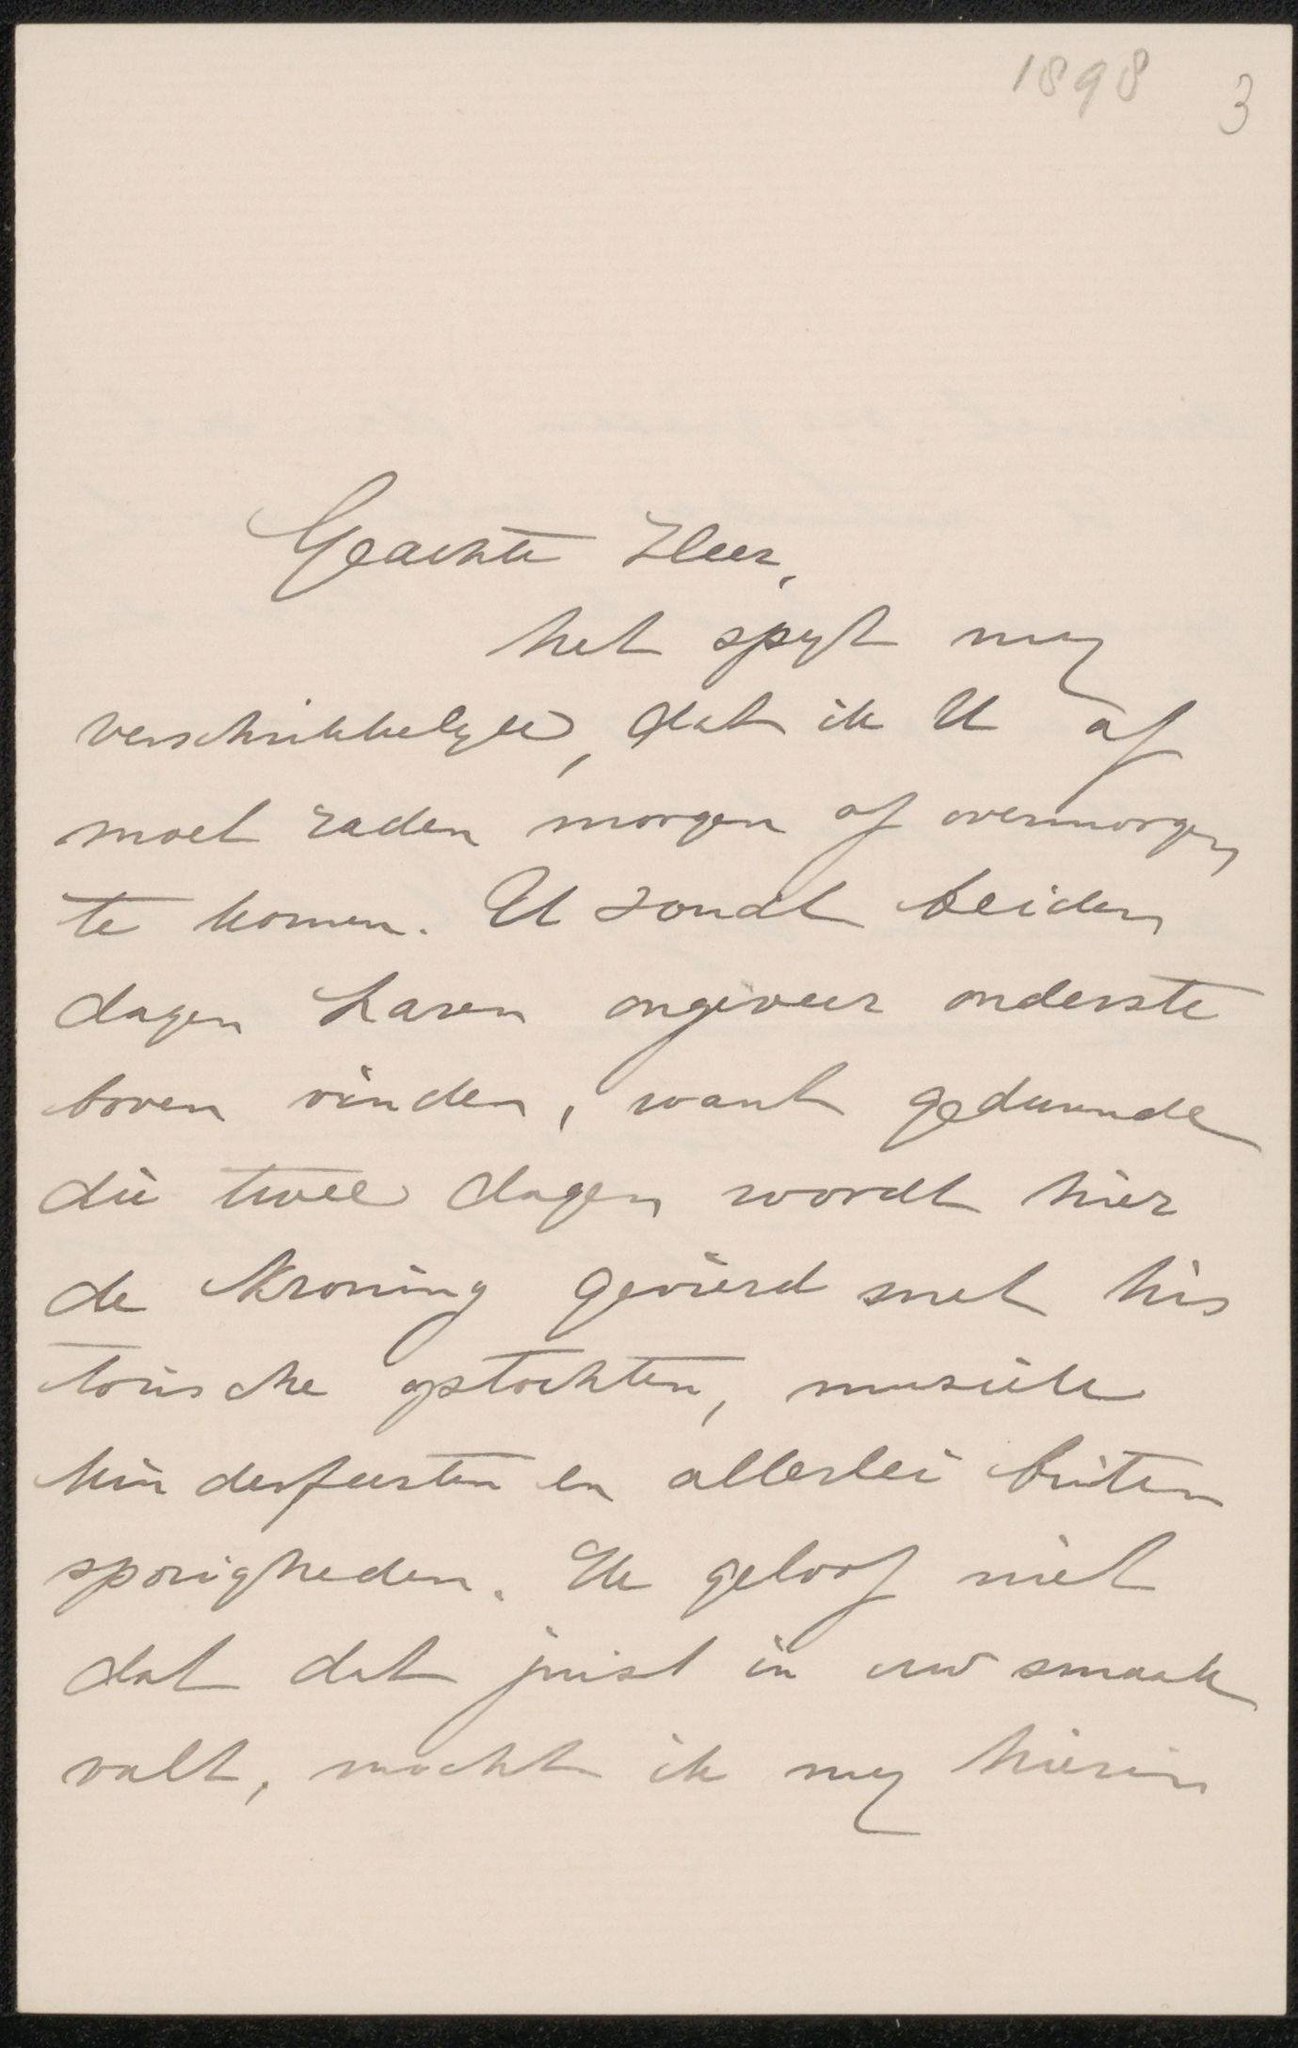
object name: letter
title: Brief aan August Allebé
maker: wally moes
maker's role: draughtsman, print maker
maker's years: 1856-1918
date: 1866-1918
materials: ink, paper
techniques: pen, writing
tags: amsterdam, print maker, draughtsman, august allebé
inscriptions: watermark